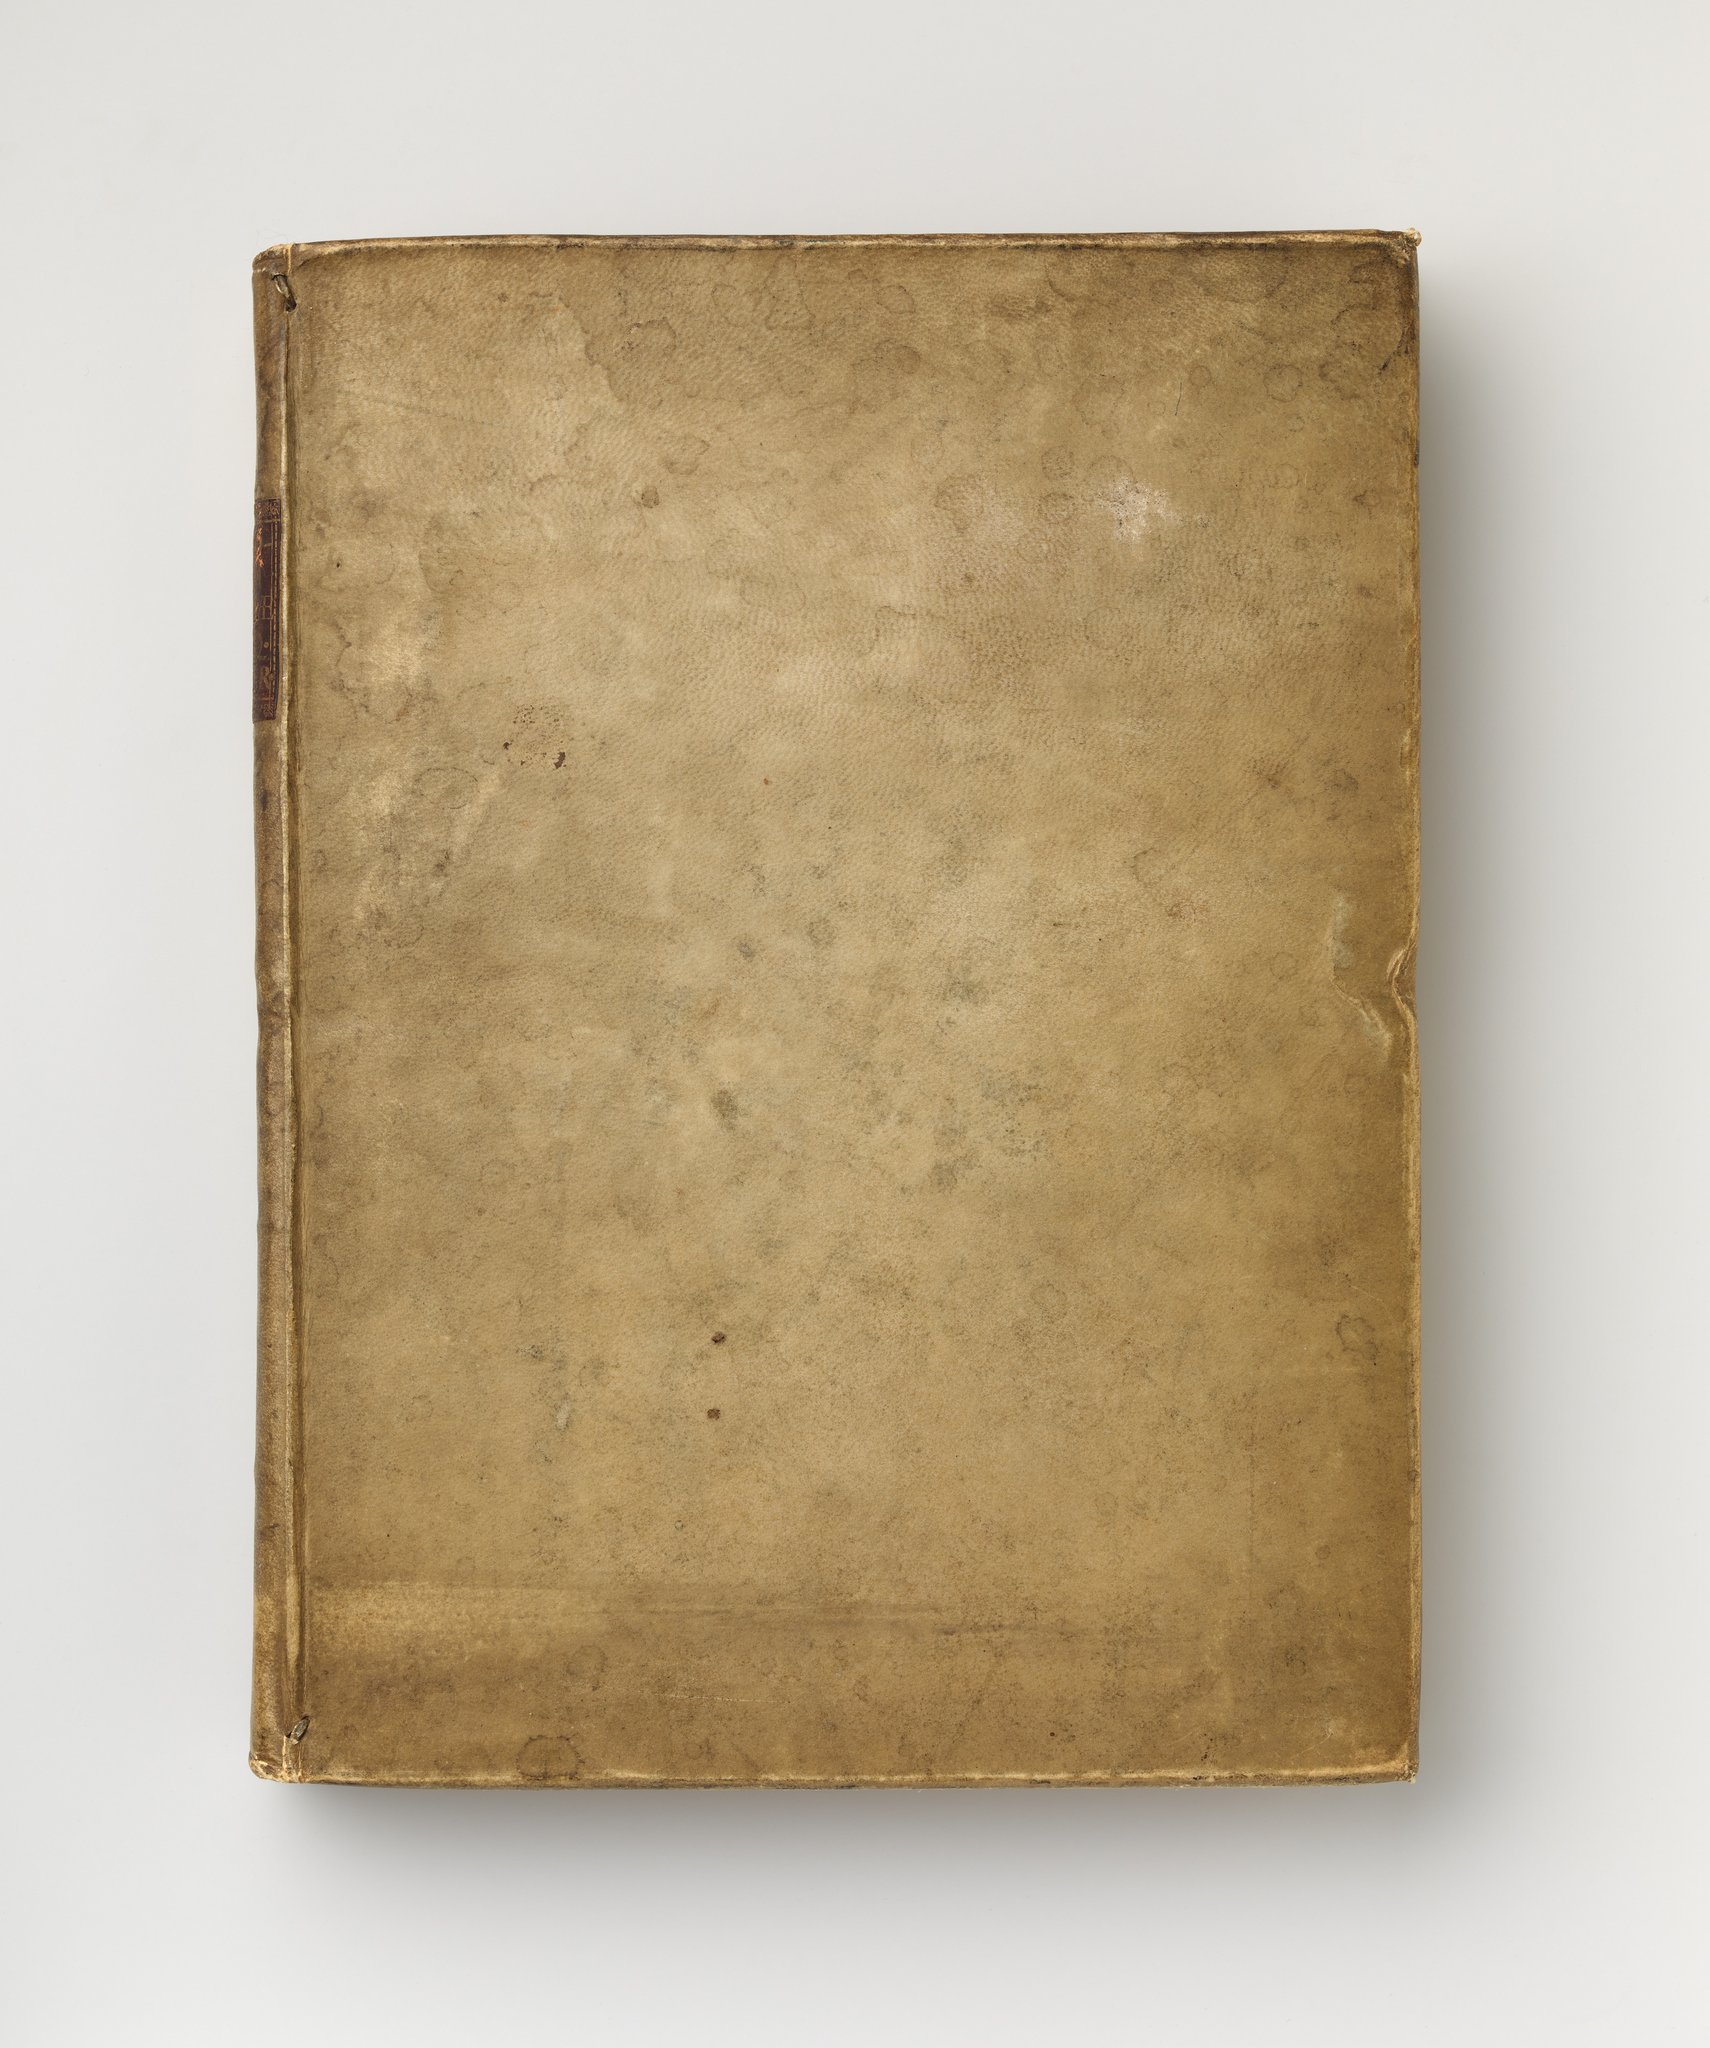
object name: book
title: Science Books: Gemmae Antiquae Litteratae; Espozione Anatomica della Struttura del Corpo Umano del Winslow, tradotto dal Franzese (...) tome 1 and 2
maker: francesco ficoroni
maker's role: author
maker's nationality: italian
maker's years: 1664-1747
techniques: etching, letterpress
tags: human figures,skeletons